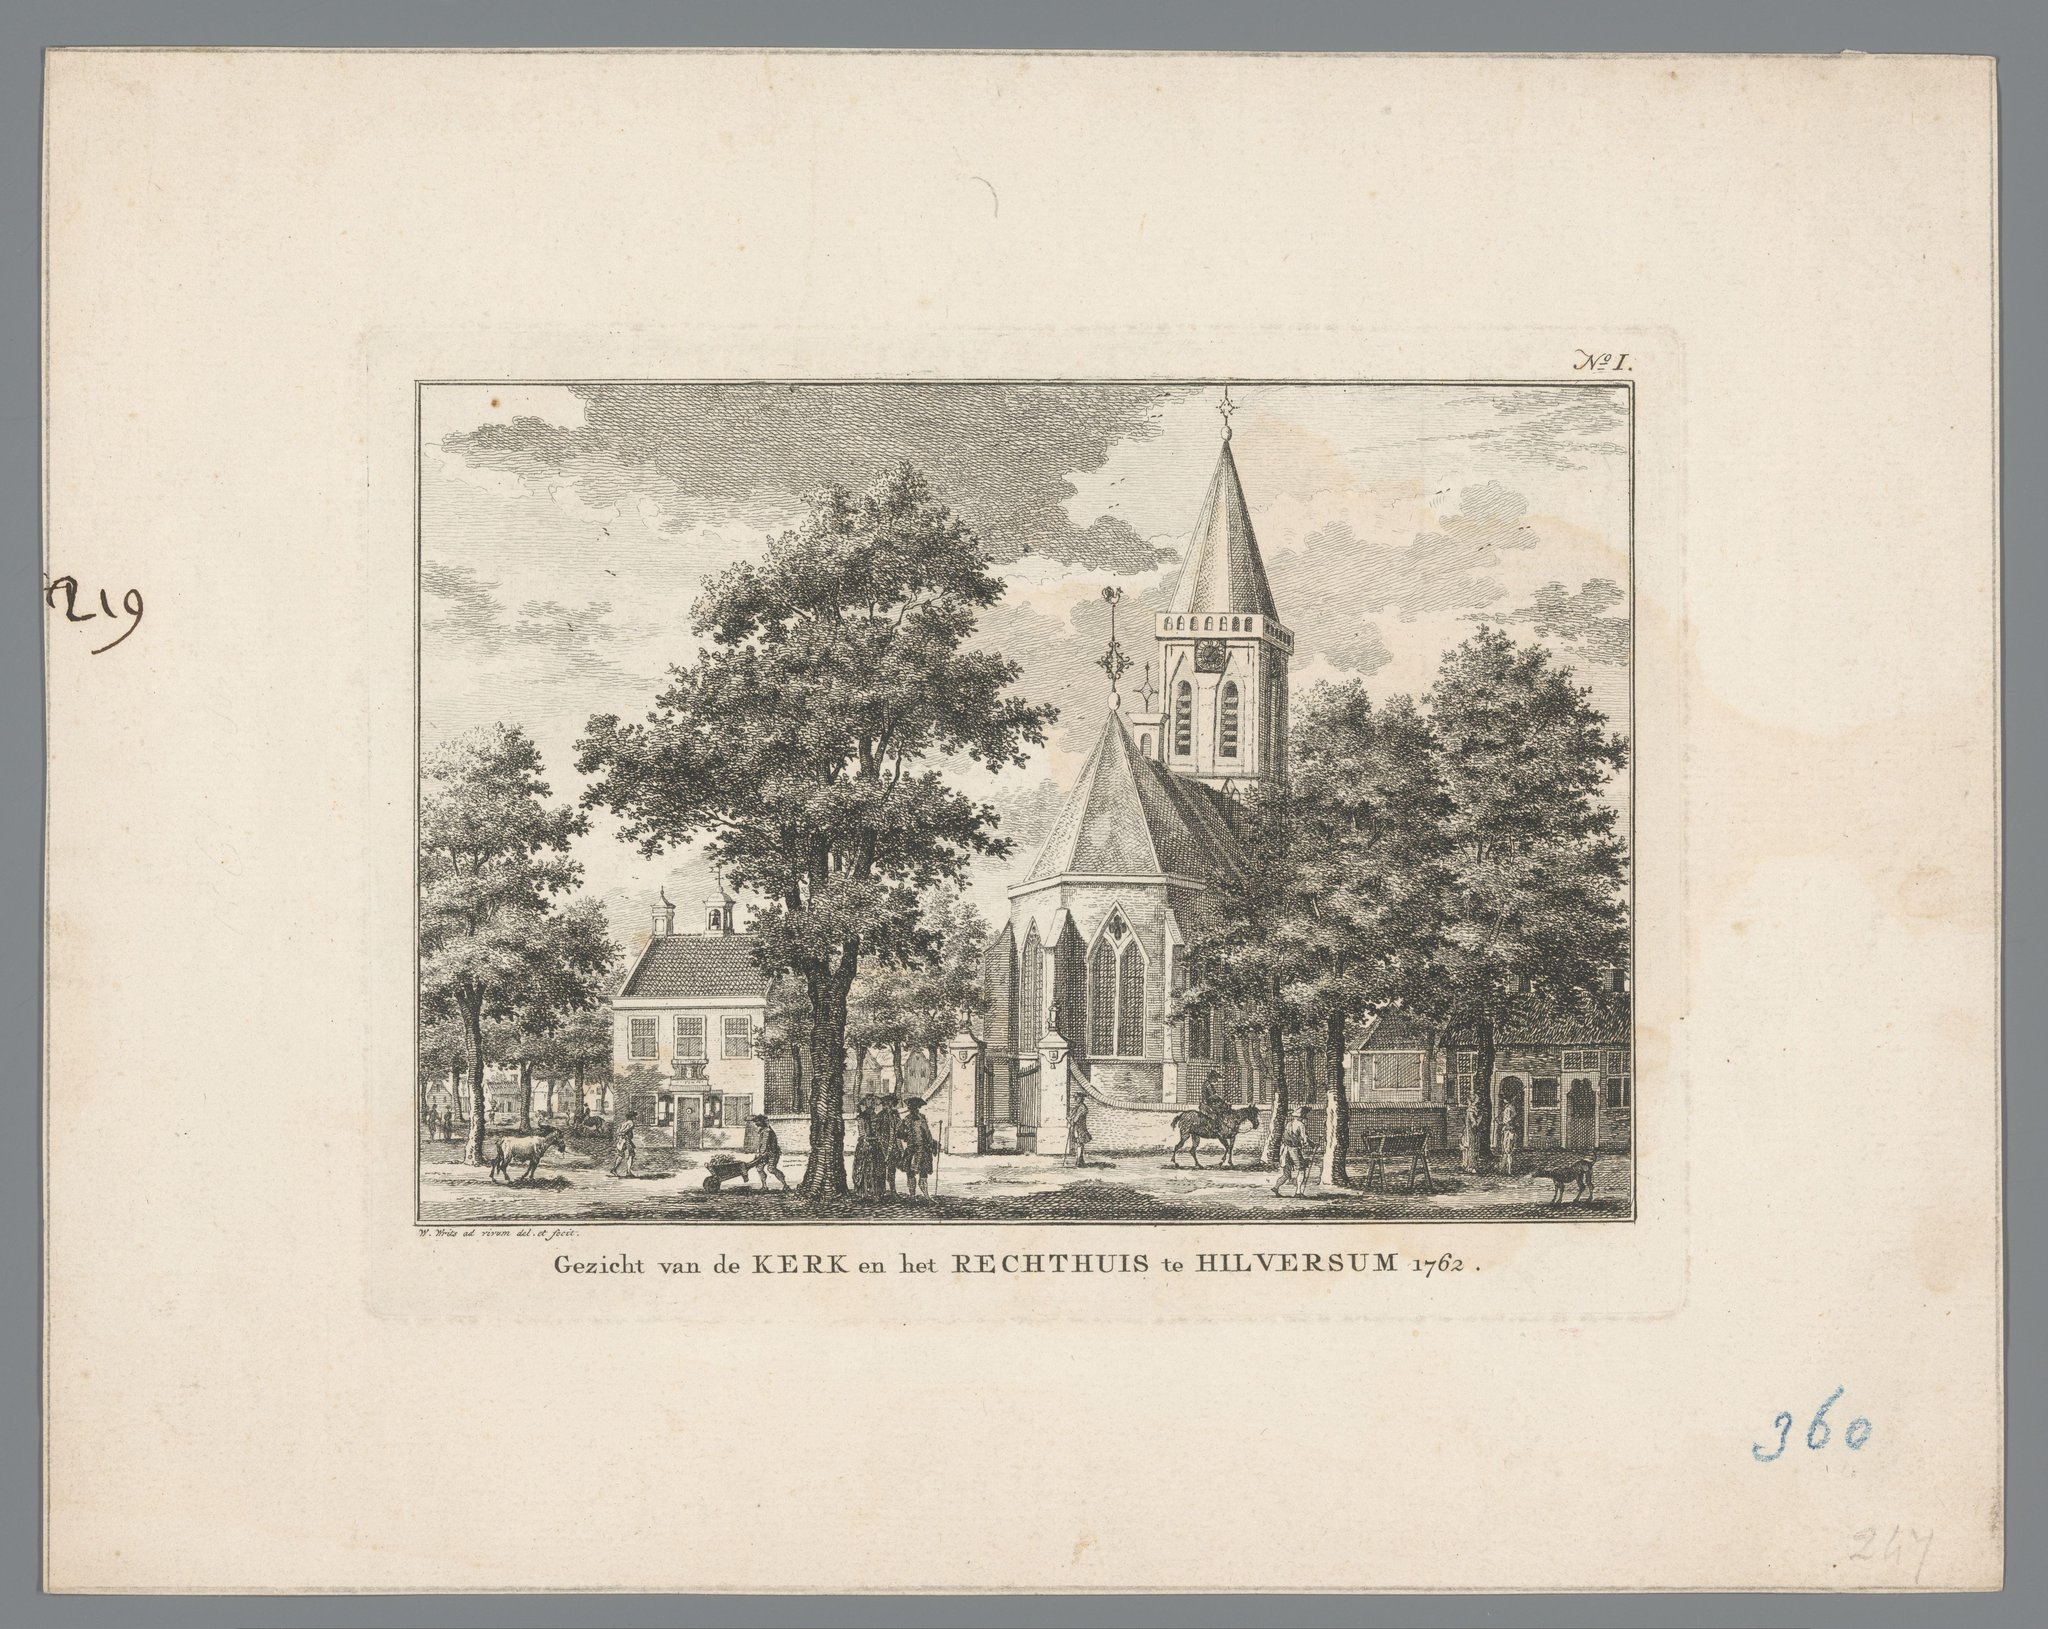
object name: print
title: Gezicht op de kerk en het rechthuis te Hilversum, 1762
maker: willem writs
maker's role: draughtsman, print maker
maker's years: 1731-1786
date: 1766-1786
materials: paper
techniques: etching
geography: amsterdam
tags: church (exterior), village street (+ city(-scape) with figures, staffage)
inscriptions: collector's mark: Lugt 2228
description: Bij deze prent hoort een andere prent van de kerk in Hilversum na de brand van 1766, zie RP-P-1914-5031.